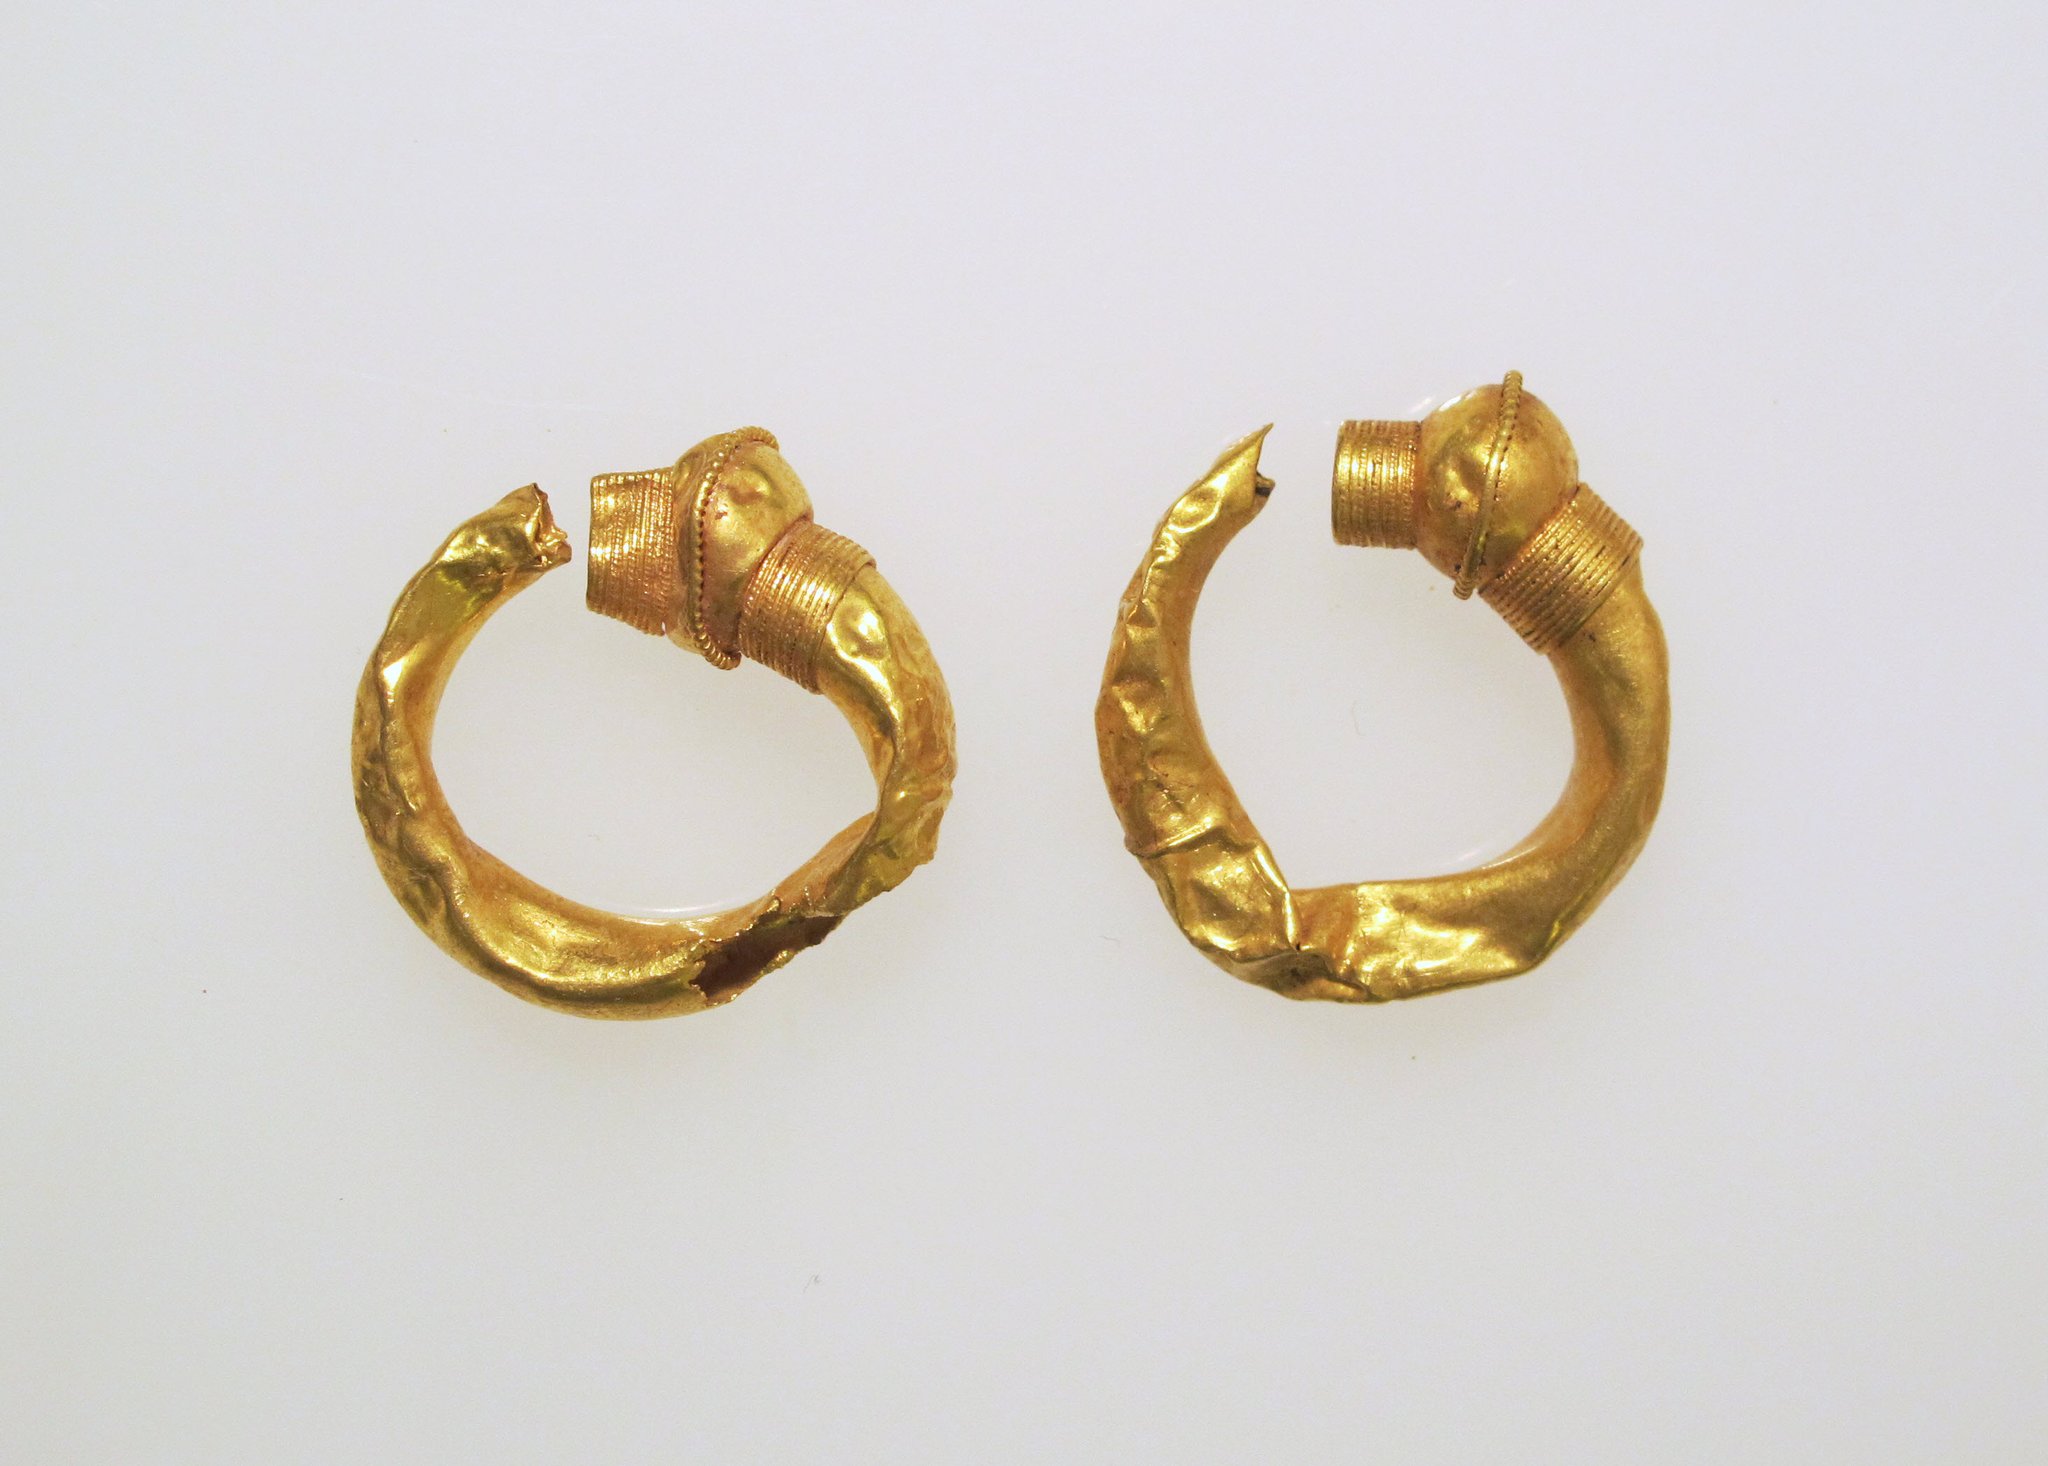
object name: earring, trumpet shaped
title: Earring, trumpet-shaped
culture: etruscan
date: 500-201 BCE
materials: gold